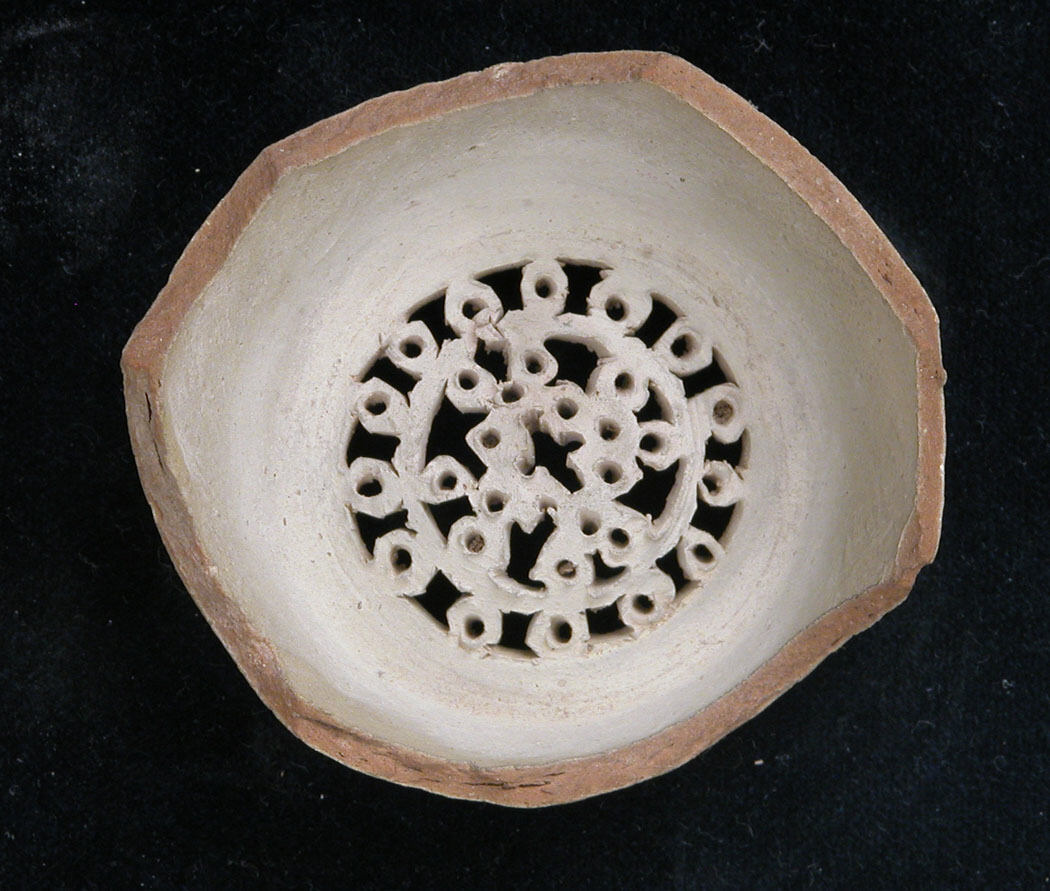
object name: water filter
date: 901-1200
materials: earthenware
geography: egypt